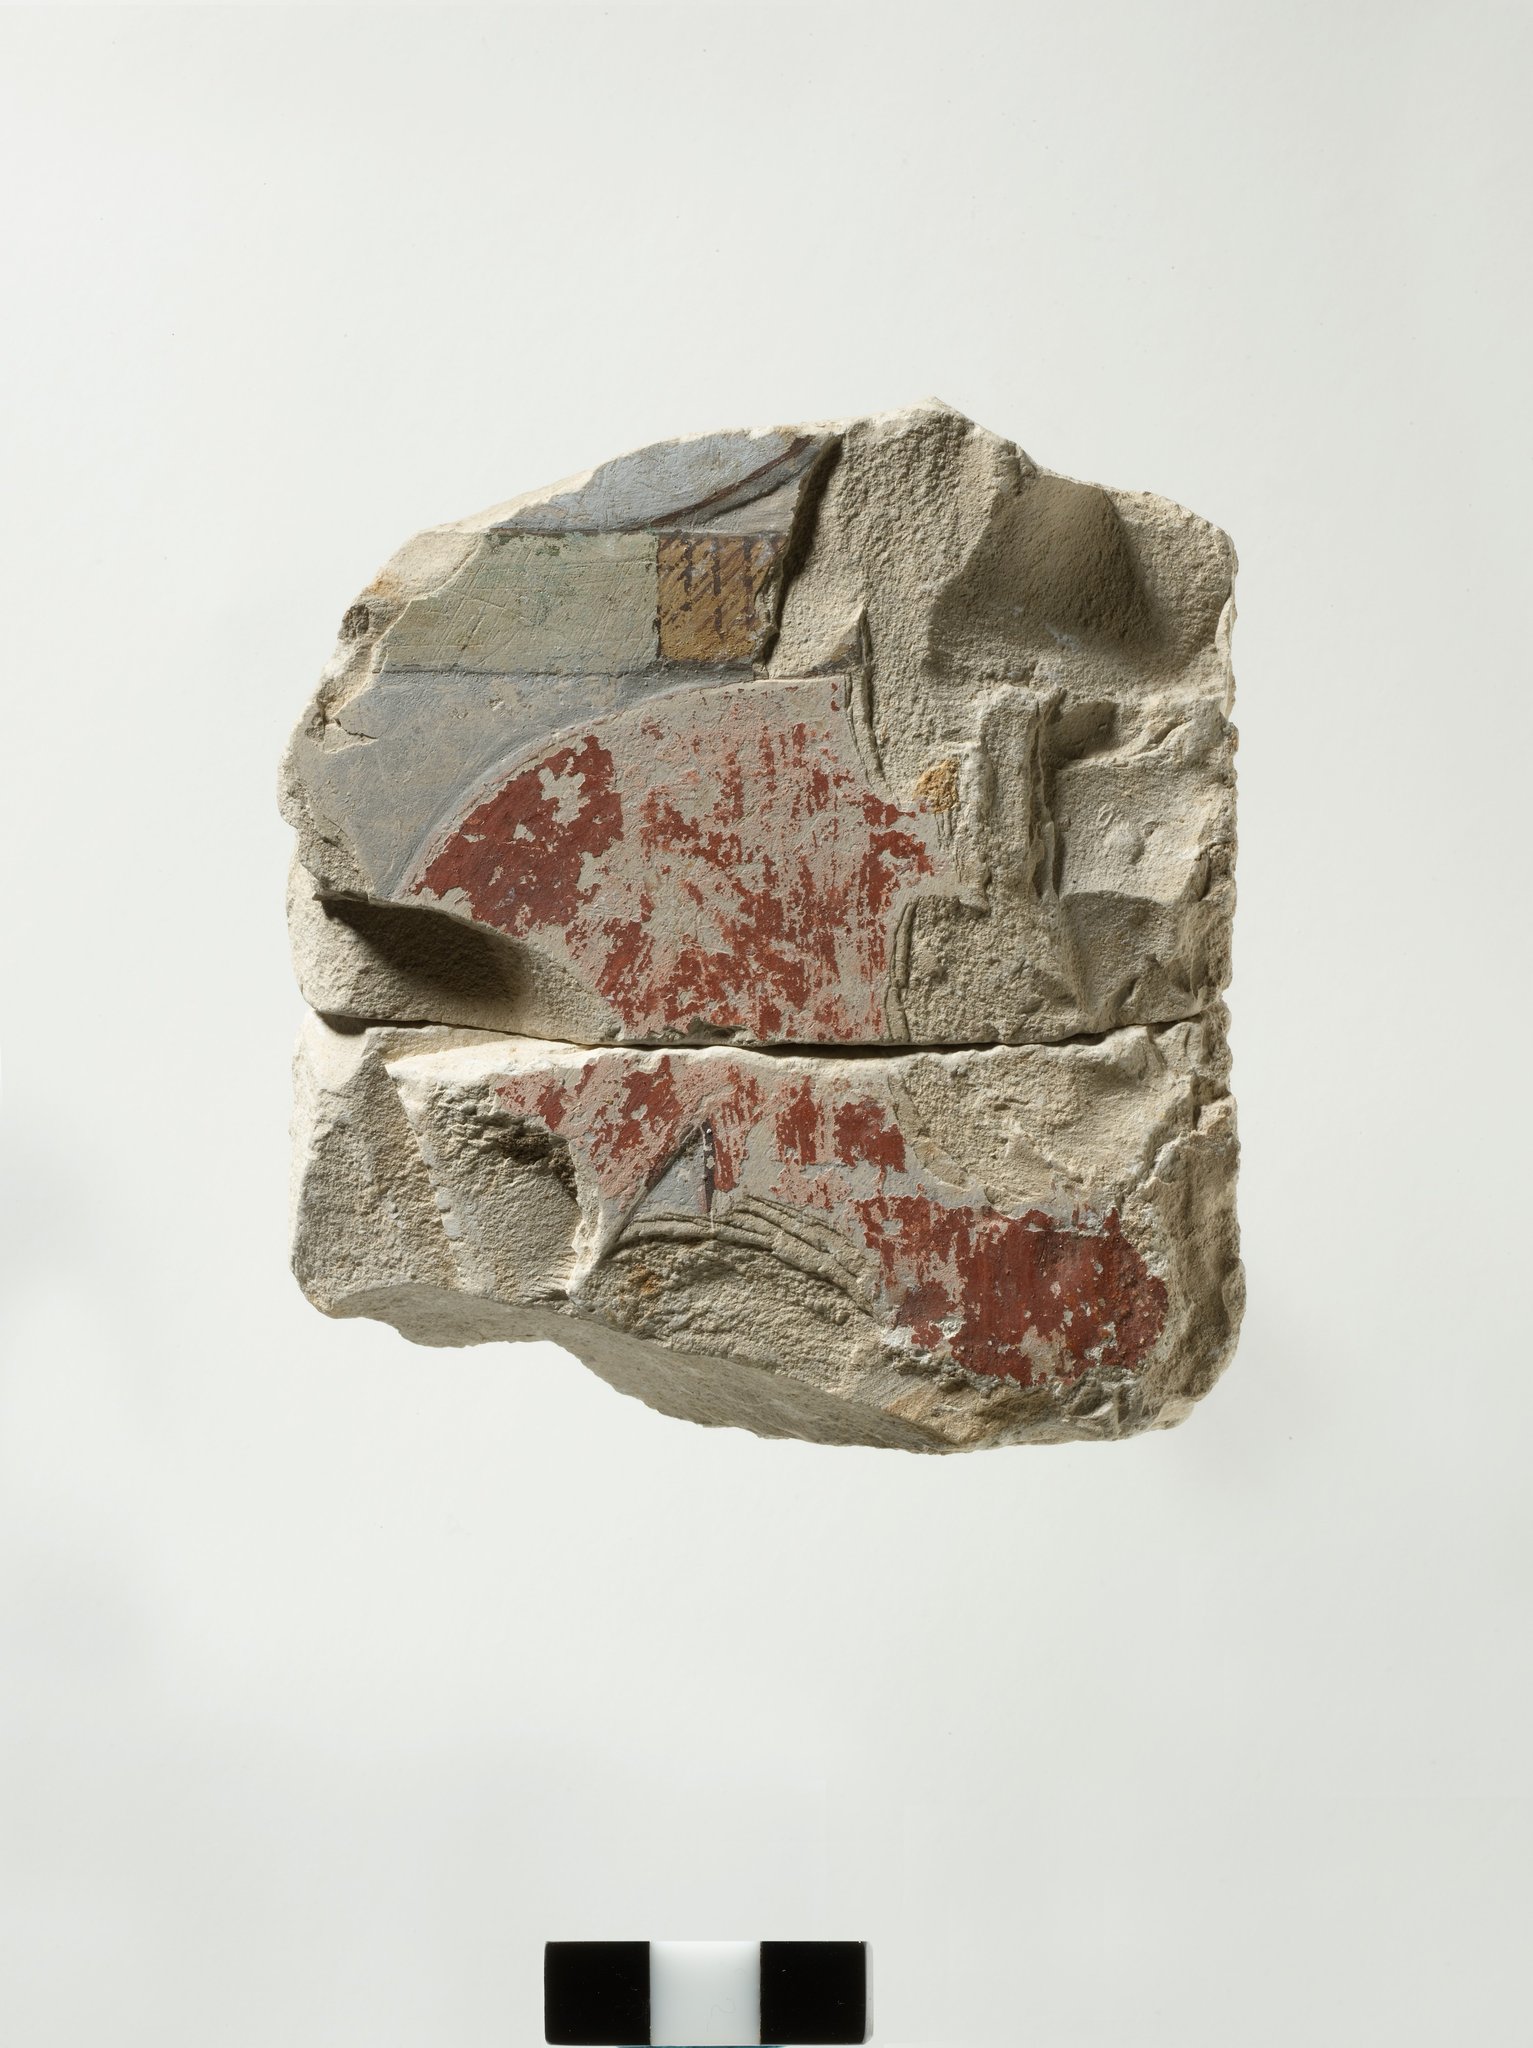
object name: relief fragment, tomb of meketre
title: Relief fragment from the tomb of Meketre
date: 1981-1975 BCE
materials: limestone, paint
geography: egypt